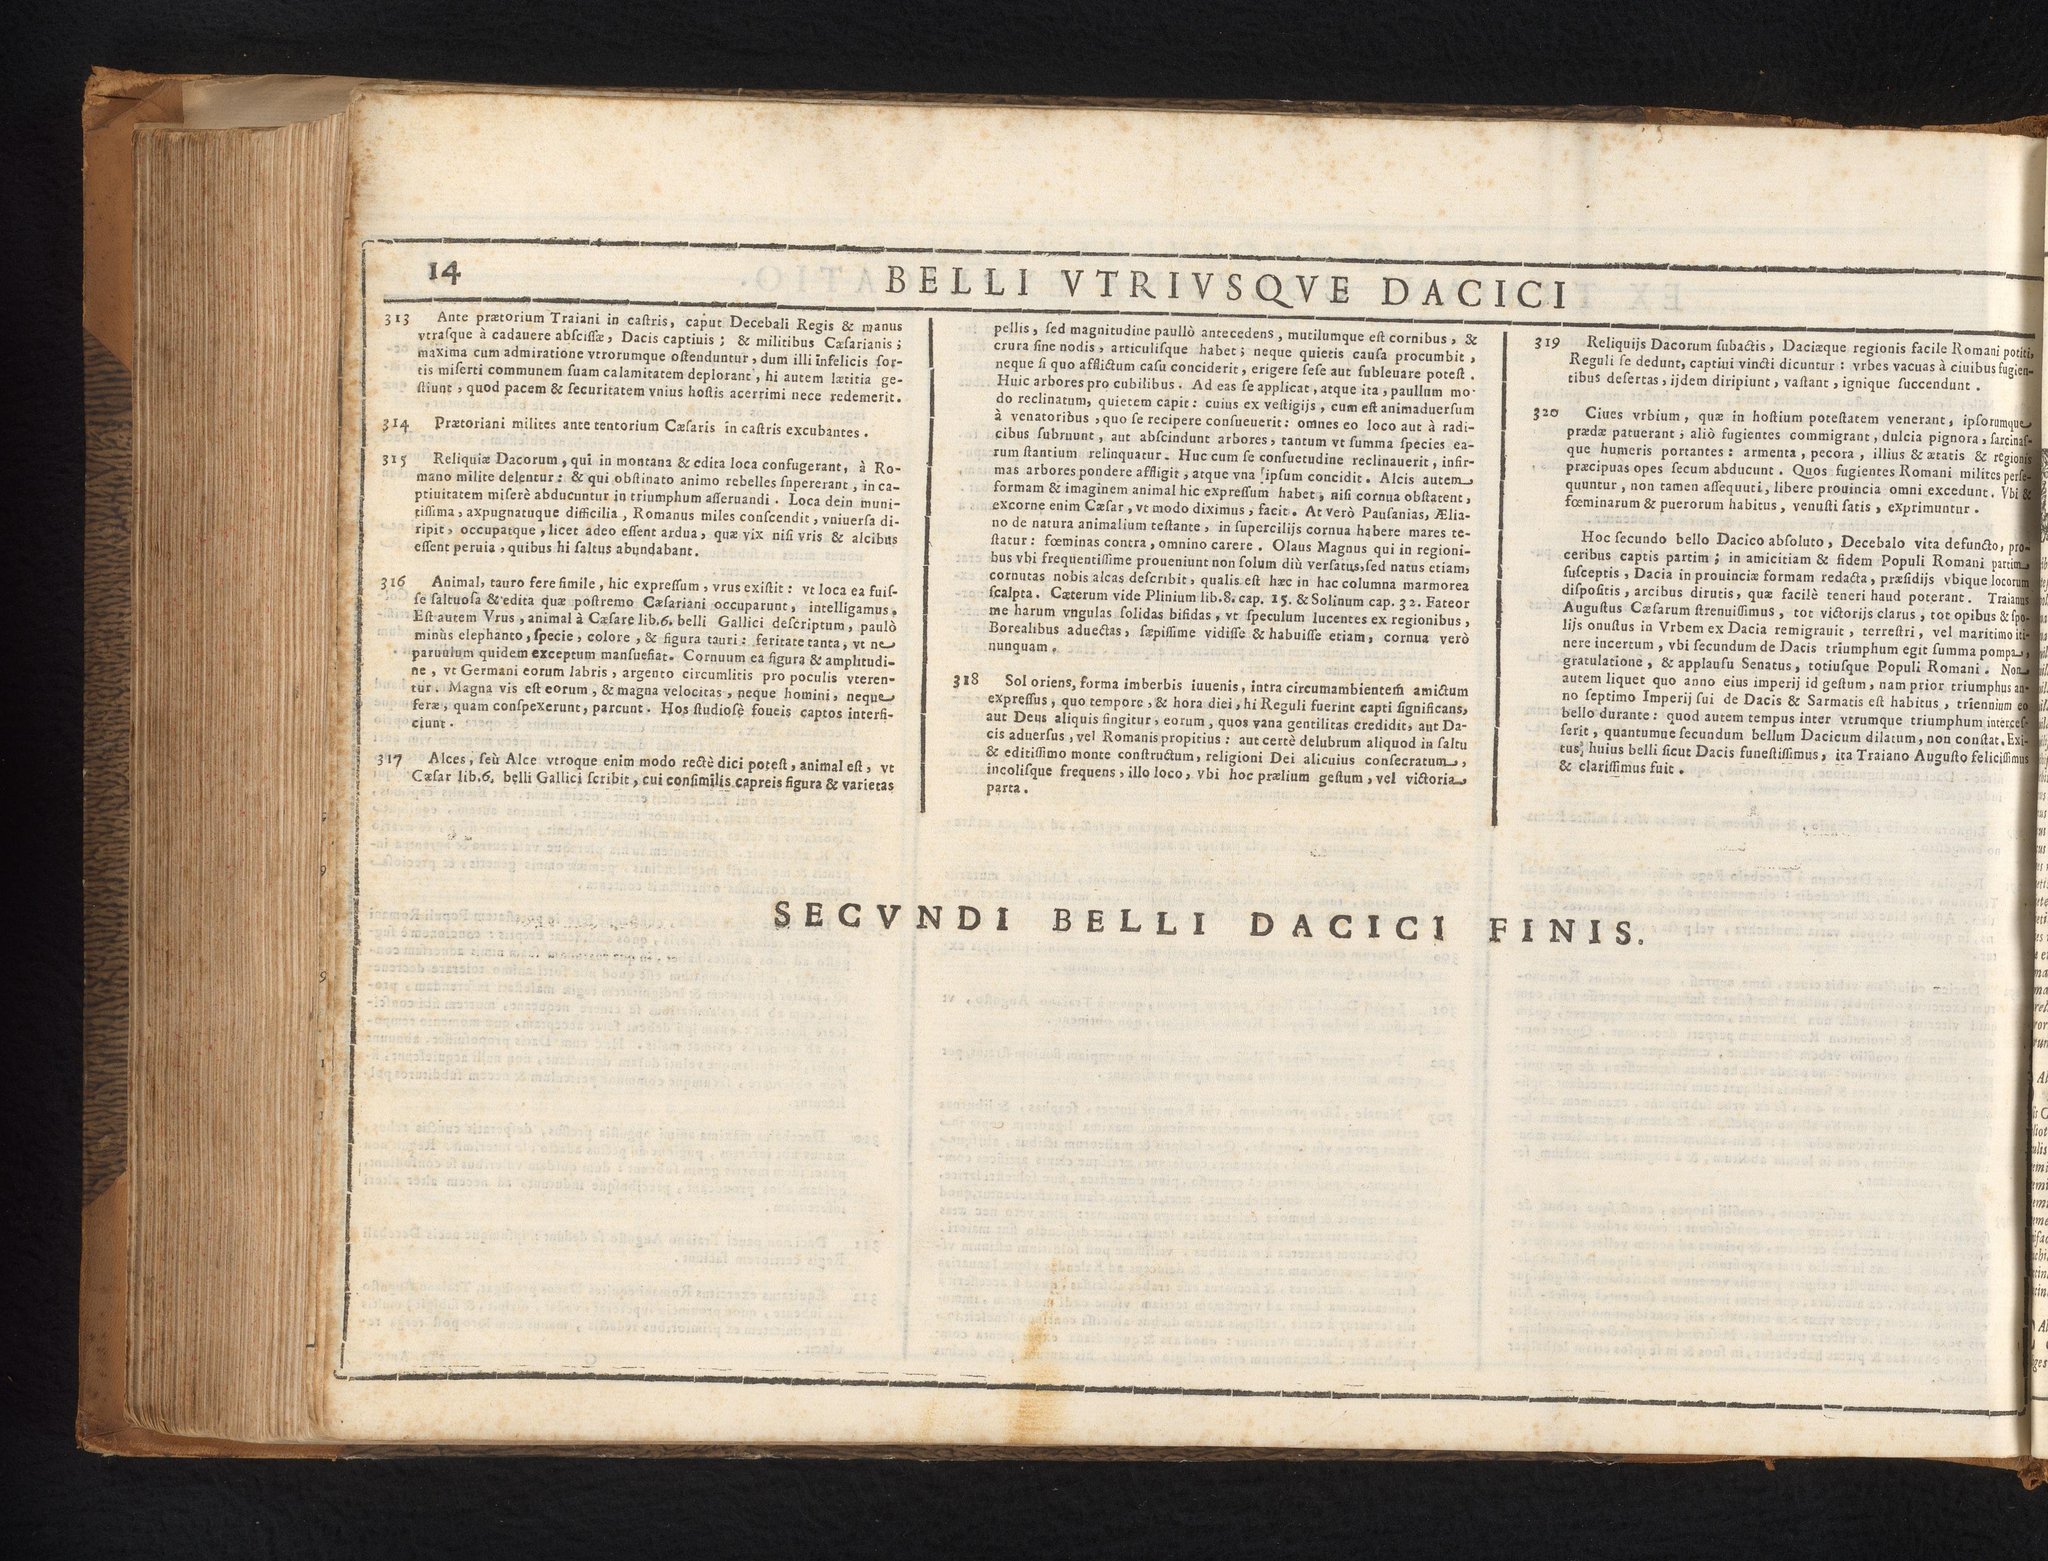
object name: print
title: Zuil van Trajanus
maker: Anonymous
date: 1550-1599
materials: paper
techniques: letterpress printing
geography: rome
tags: zuil van trajanus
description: Een beschrijving van scènes 313 tot en met 320 op de Zuil van Trajanus, in het Italiaans. Prent maakt deel uit van een album.